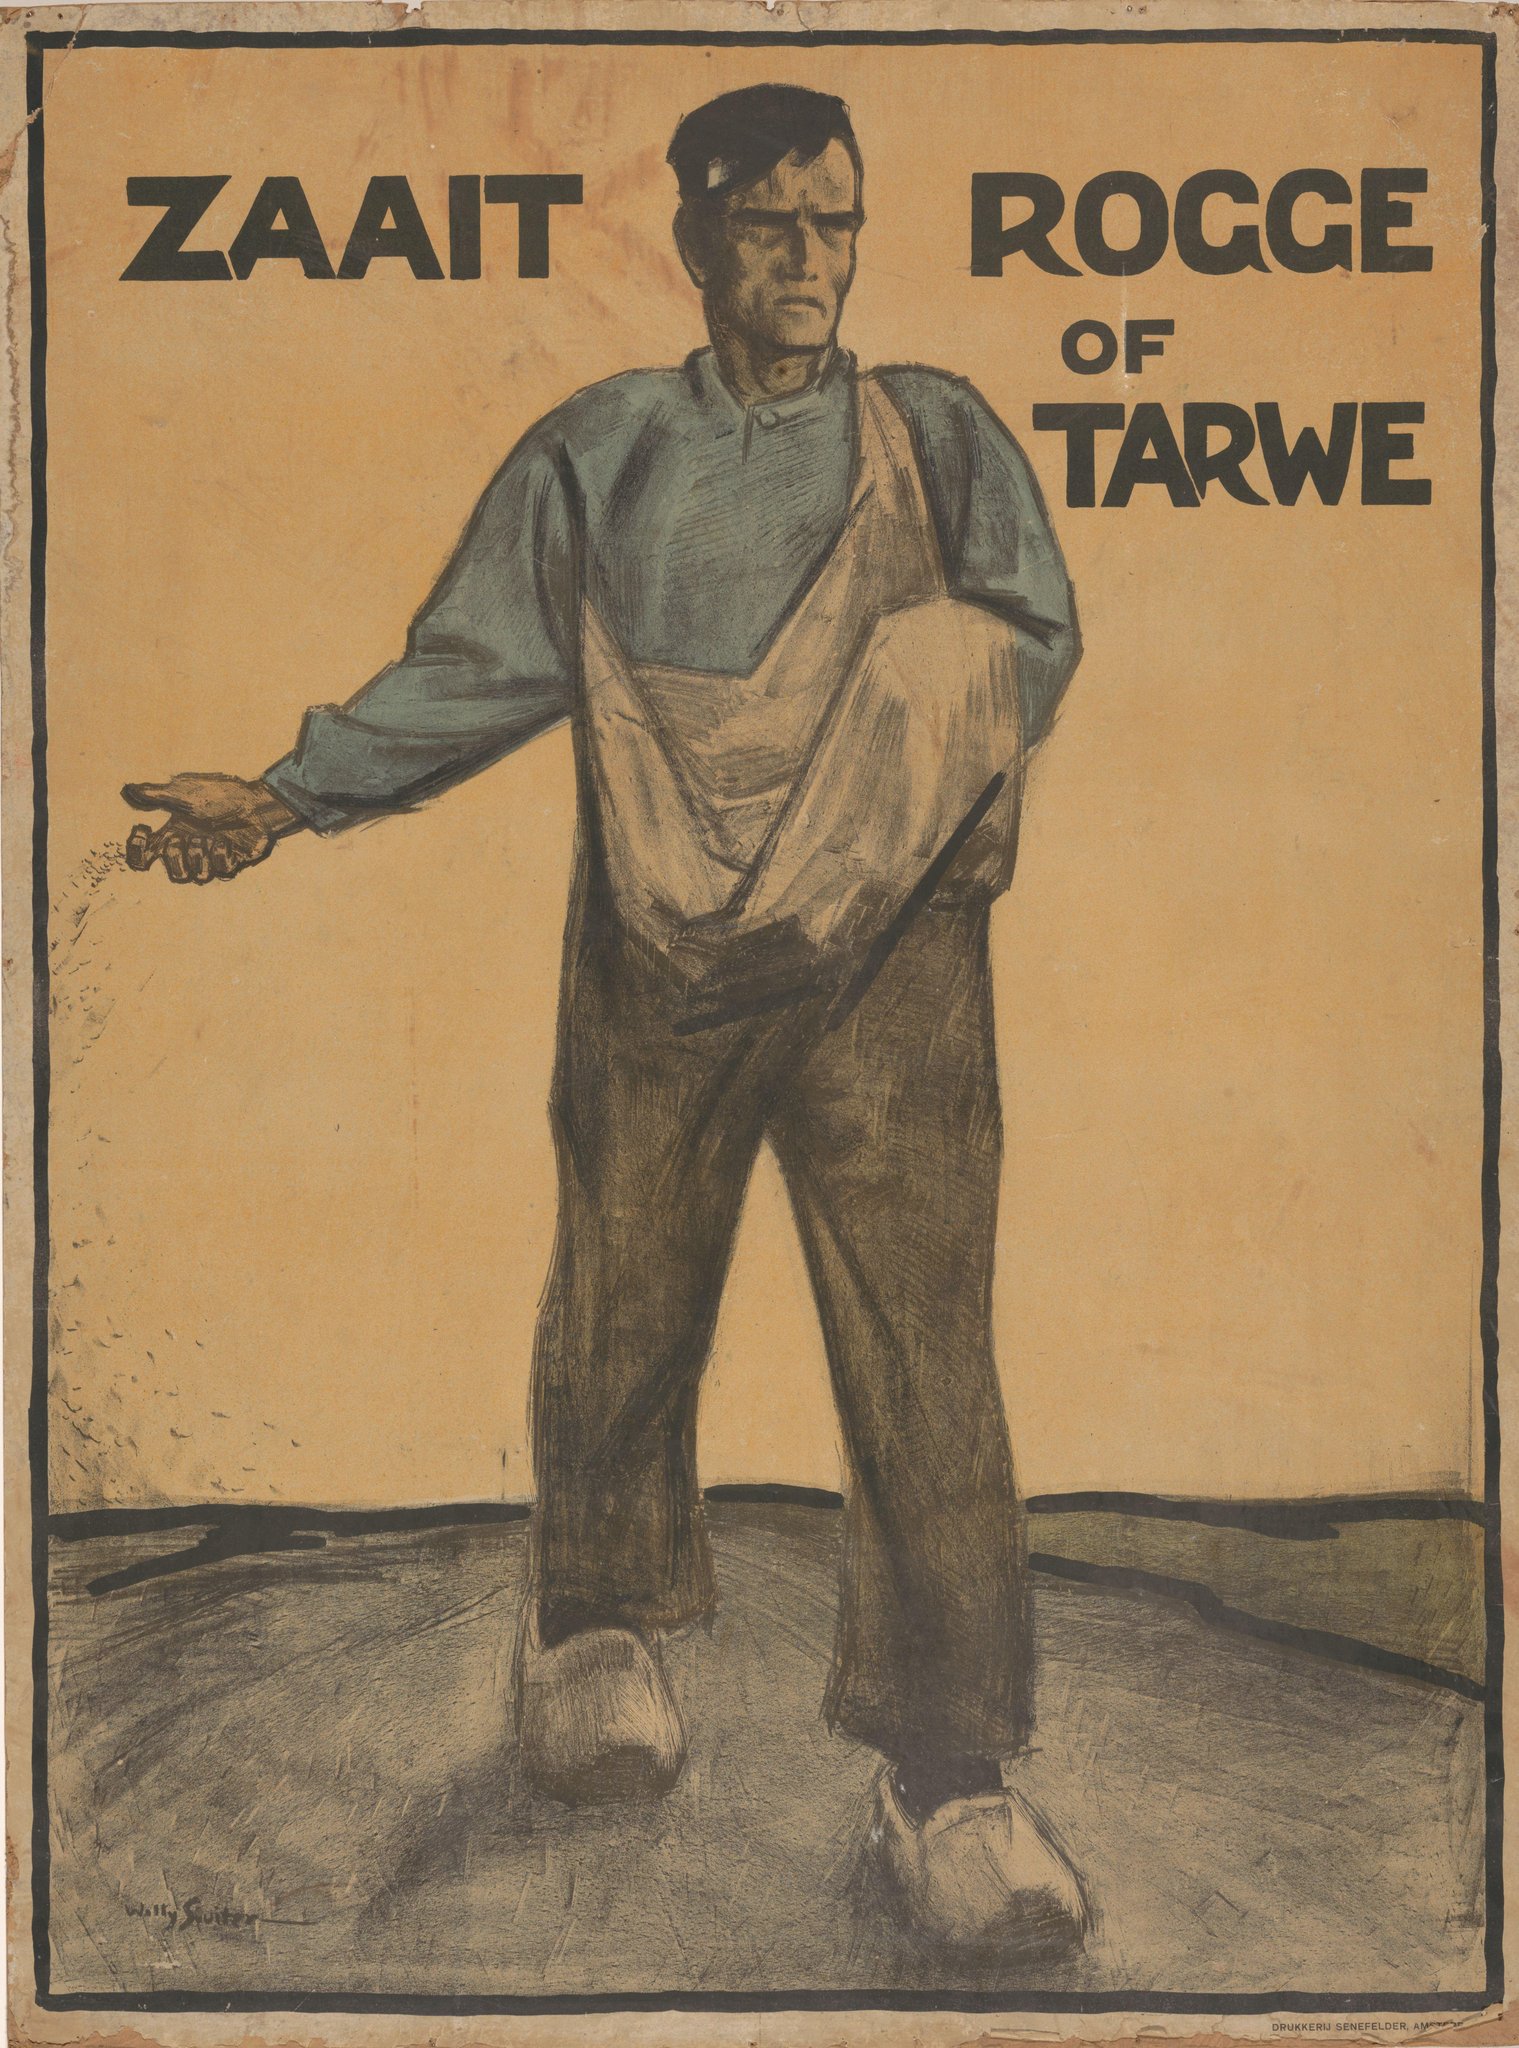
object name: poster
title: Zaait rogge of tarwe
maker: willy sluiter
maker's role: draughtsman, painter, print maker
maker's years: 1873-1949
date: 1918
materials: paper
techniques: lithograph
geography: amsterdam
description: Affiche, waarop een zaaiende boer; gele lucht, zwarte grond. Gesigneerd. Geplakt op karton. Achterzijde beplakt met kranten van 'De Telegraaf' van zaterdag 10 februari 1923.